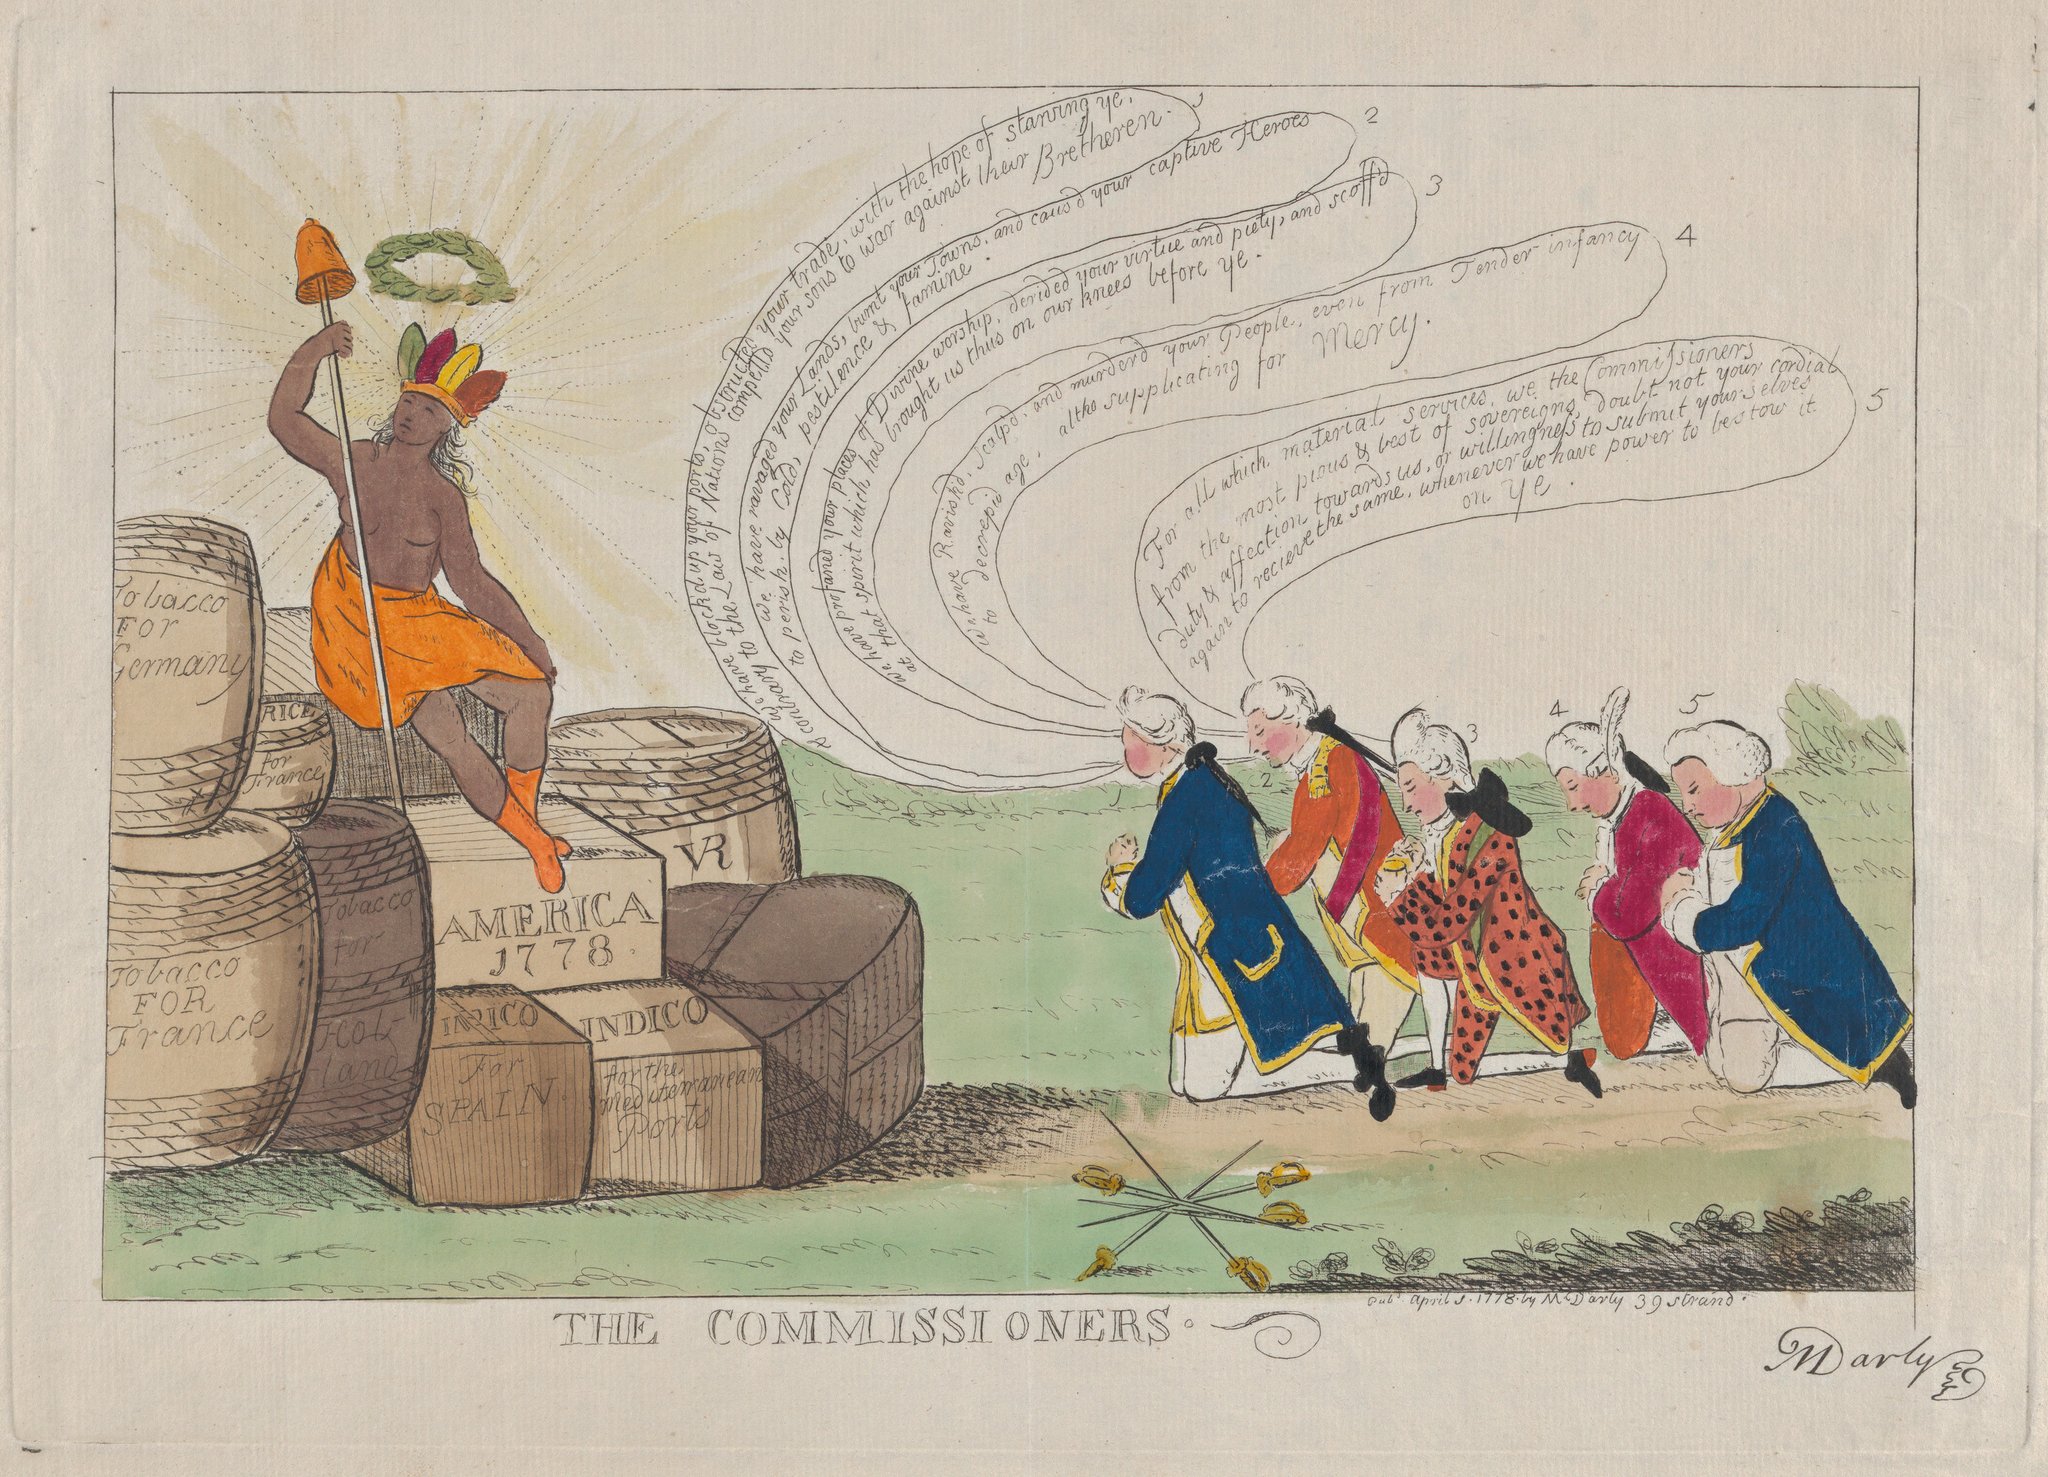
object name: print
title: The Commissioners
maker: matthias darly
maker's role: publisher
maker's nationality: british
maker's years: 1720-1780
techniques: etching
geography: london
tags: satire,american revolution,men,politics